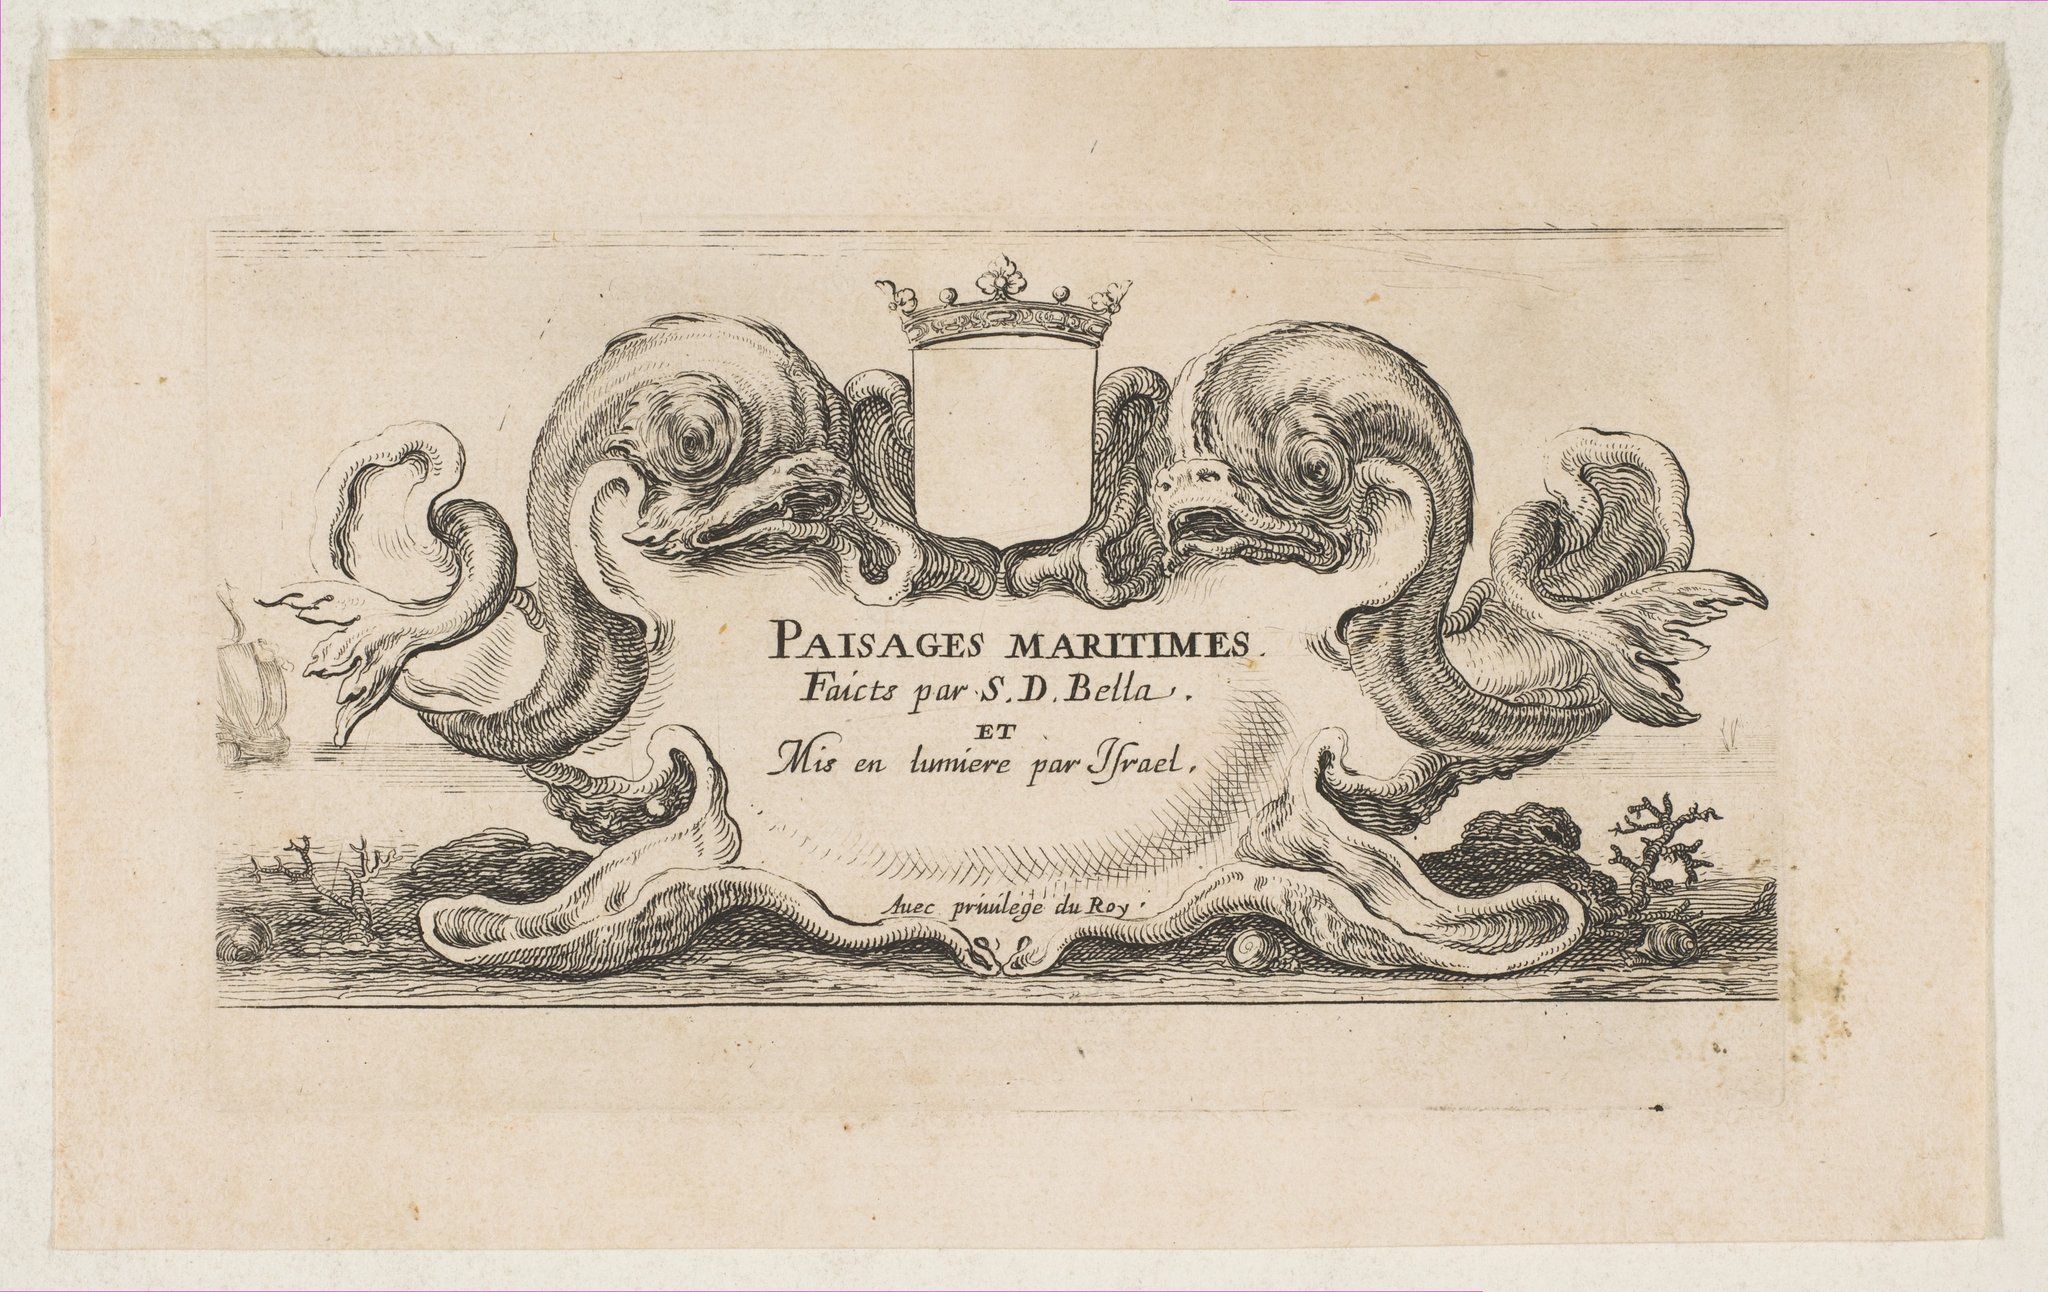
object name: print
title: Title Page: Paisages maritimes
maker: stefano della bella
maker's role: artist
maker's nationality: italian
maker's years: 1610-1664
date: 1644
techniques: etching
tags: fish,insignia